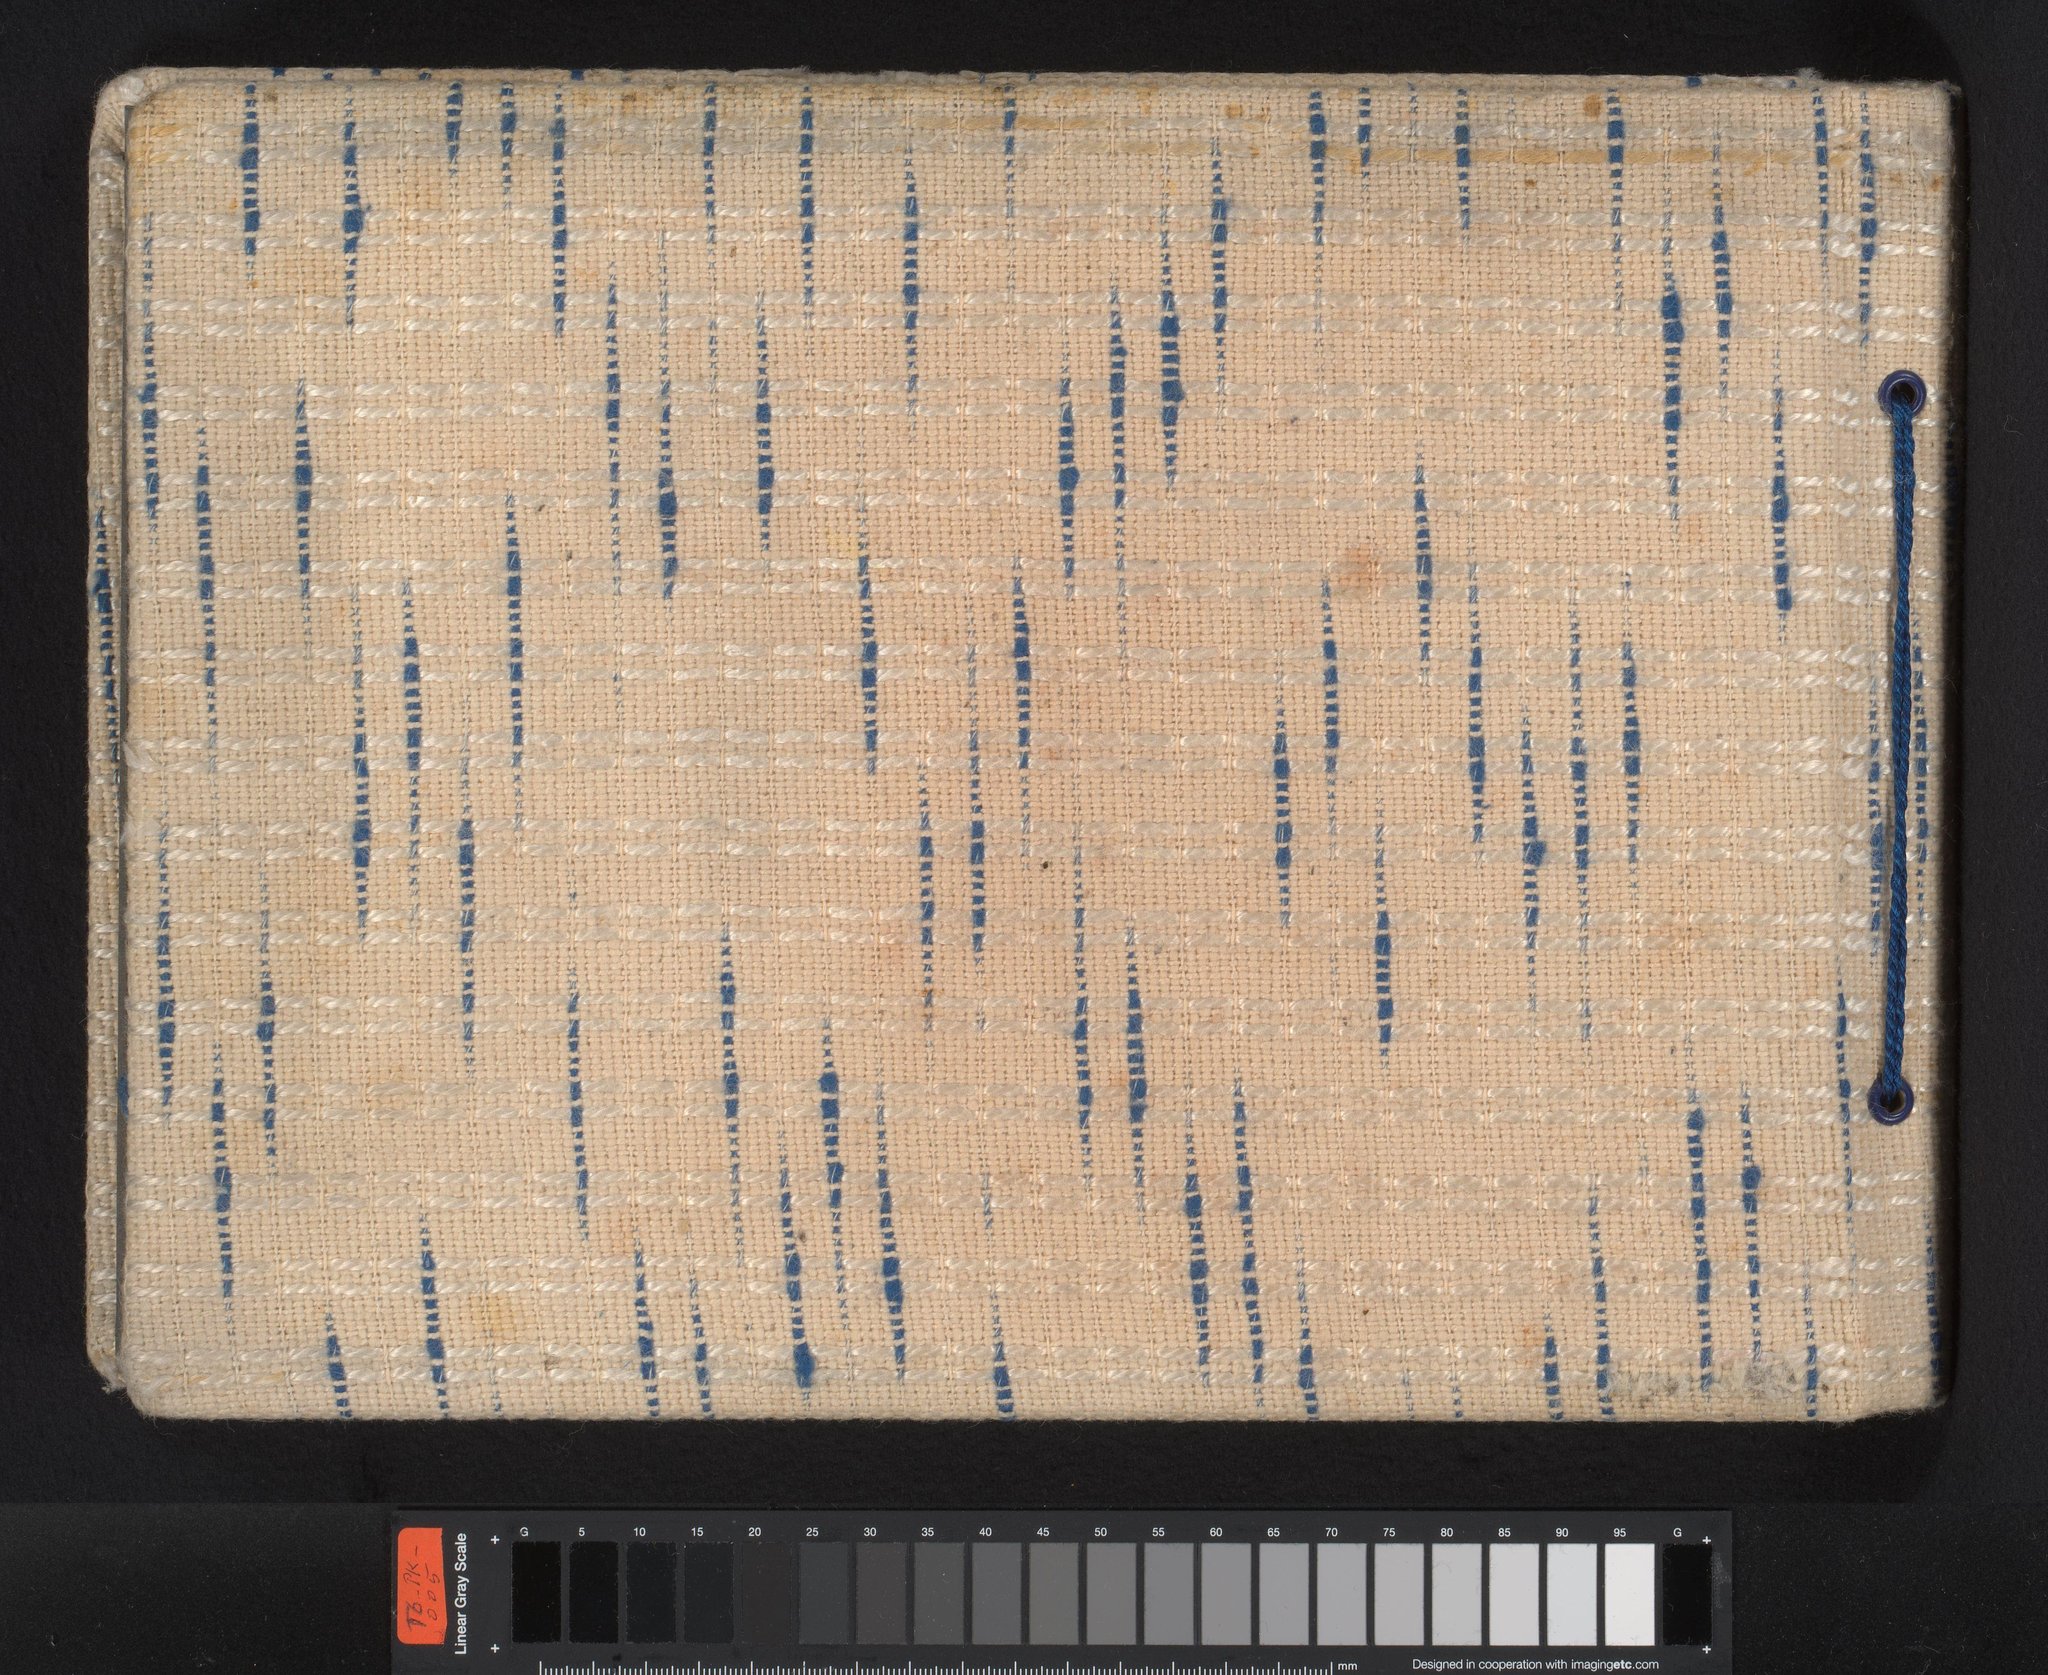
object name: endleaf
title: Joegoslavië, april 1943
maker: Anonymous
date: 1904-1943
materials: cardboard, photographic support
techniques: gelatin silver print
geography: yugoslavia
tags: laundering, folk costume, regional costume, occupation ~ war, hanging the wash to dry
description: Schutblad achterin het album waarop geplakt drie foto's in Joegoslavië, waarschijnlijk april 1943: vrouwen in lokale dracht die de was doen in een rivier en het wasgoed ophangen in de buitenlucht in een boomgaard. Onderdeel van het fotoalbum Abrechnungsintendantur van de Wehrmacht 1941-1943.